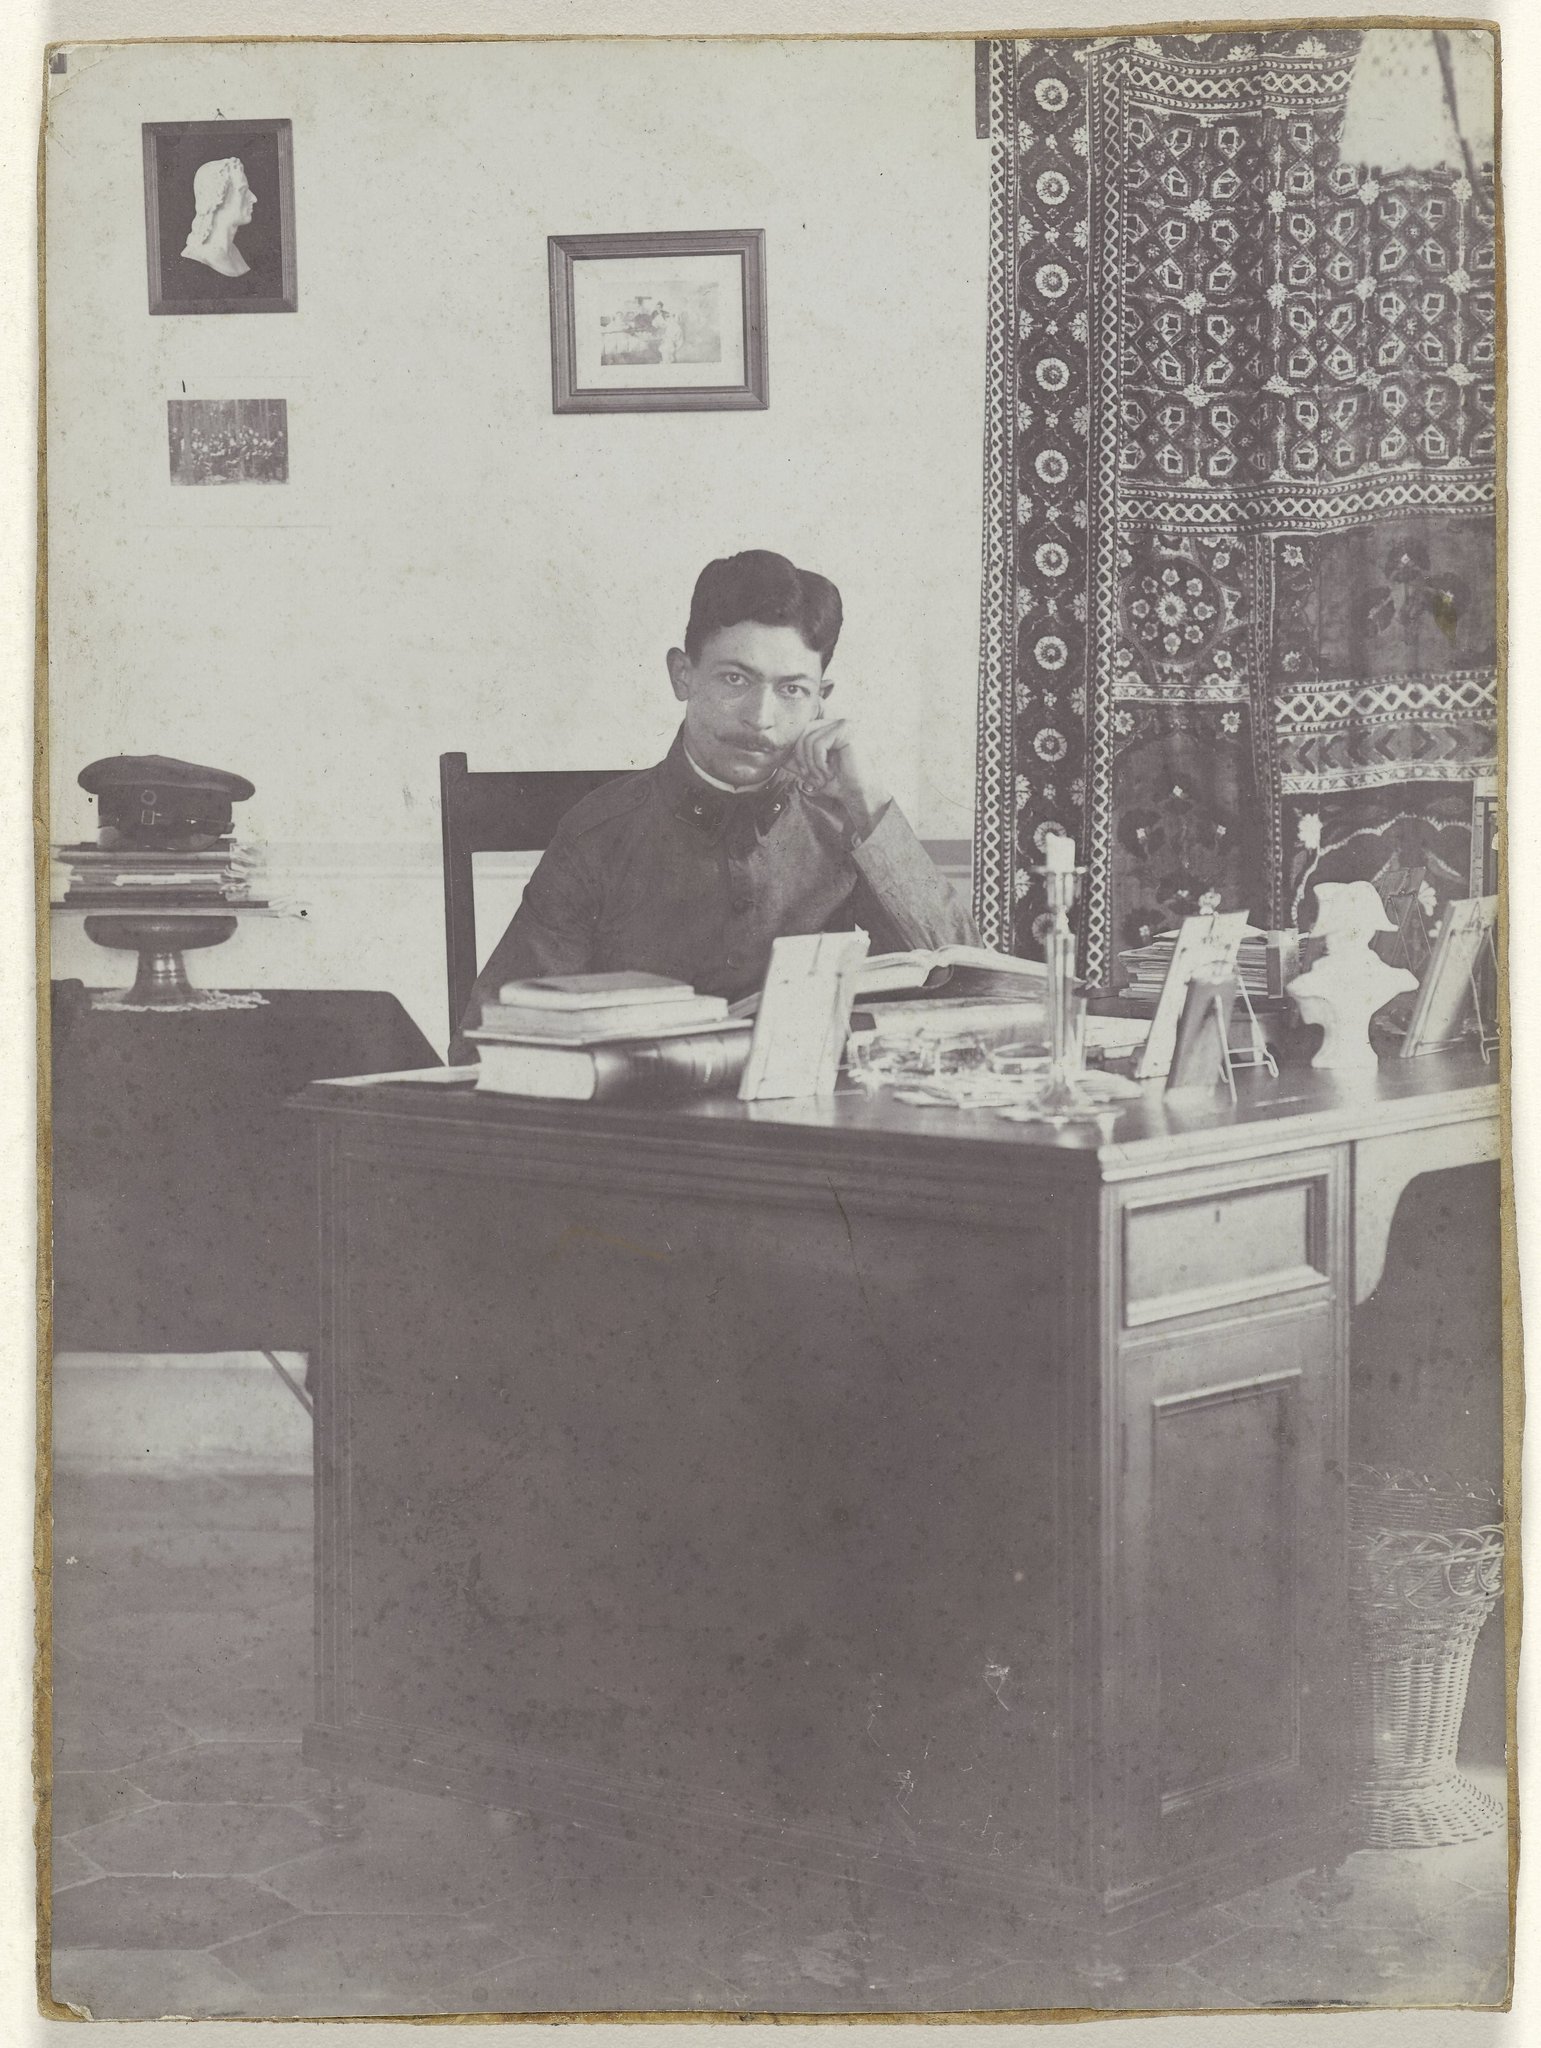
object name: photograph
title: Portret van een Indische man achter zijn bureau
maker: Anonymous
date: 1890-1920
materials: paper, cardboard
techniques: gelatin silver print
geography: dutch east indies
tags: writing-table, writing-desk, adult man, anonymous historical person portrayed, dutch east indies, the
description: Zie gerelateerde objecten voor andere foto's van dezelfde man.